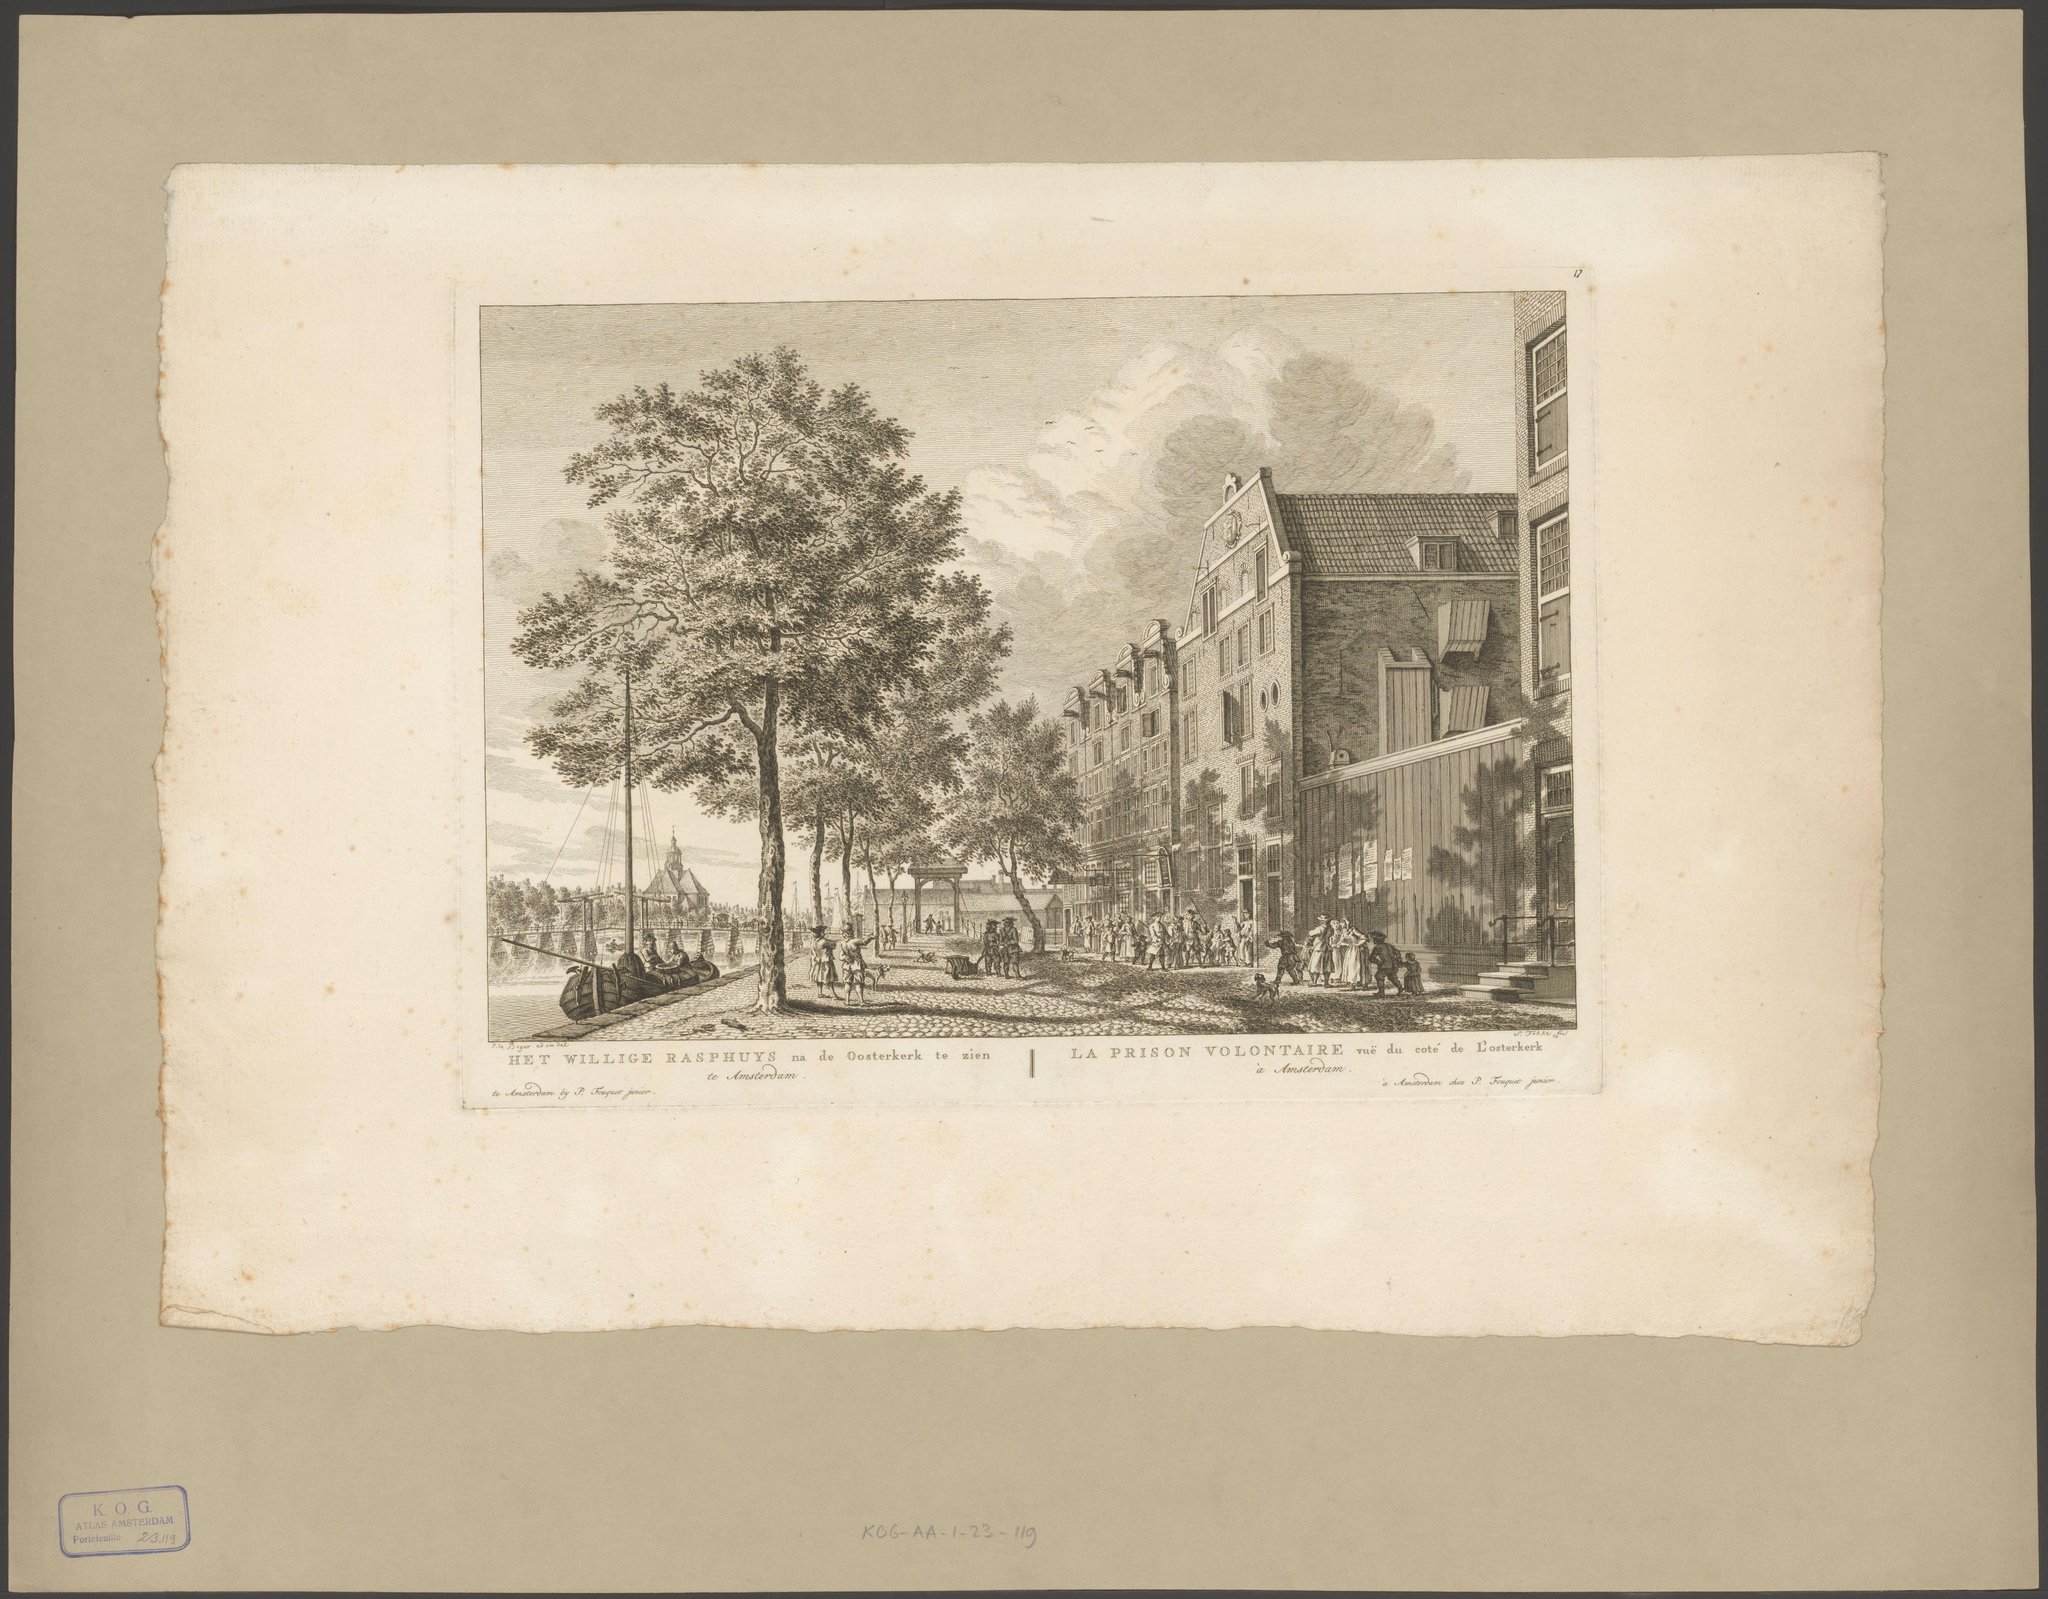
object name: print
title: Atlas van Fouquet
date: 1760-1783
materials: paper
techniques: engraving, etching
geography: amsterdam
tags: prison, jail, canals, waters (in city), workhouse, penal camp, penitentiary, chain gang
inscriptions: collector's mark: Lugt 1641b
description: Vanaf 1760 gaf Pierre Fouquet stadsgezichten van Amsterdam naar tekeningen van verschillende kunstenaars uit. Deze prenten werden aanvankelijk los verkocht. Later werden ze samengebonden verkocht in verschillende volgordes en aantallen in: (1). Afbeeldingen van de wyd-vermaarde koopstad Amsterdam benevens des zelvs voornaamste gebouwen en gezigten alle naar het leeven getekend / Receuil des edifices les plus considerables et des plus belles vues, de la fameuse ville d'Amsterdam, dessinées d'après nature. Amsterdam: Pierre Fouquet, 1778-1783. Deze 'uitgave' bestond waarschijnlijk alleen uit een titelblad en inhoudsopgave van de tot dusver 100 uitgegeven prenten, die de koper zelf aan zijn of haar reeds verzamelde prenten kon toevoegen. De hoeveelheid en volgorde van prenten verzameld onder deze titel verschilt dus sterk. (2). Nieuwe atlas, van de voornaamste gebouwen en gezigten der stad Amsterdam, met derzelver beknopte beschryvingen. 2 dln. Amsterdam: Daniël Jean Changuion en Petrus den Hengst [in opdracht van Pierre Fouquet], 1783. Ook werden er door verschillende uitgevers tussen 1788 (Amsterdam: Petrus Conradi) en 1805 (Amsterdam: Evert Maaskamp) heruitgaven gepubliceerd.